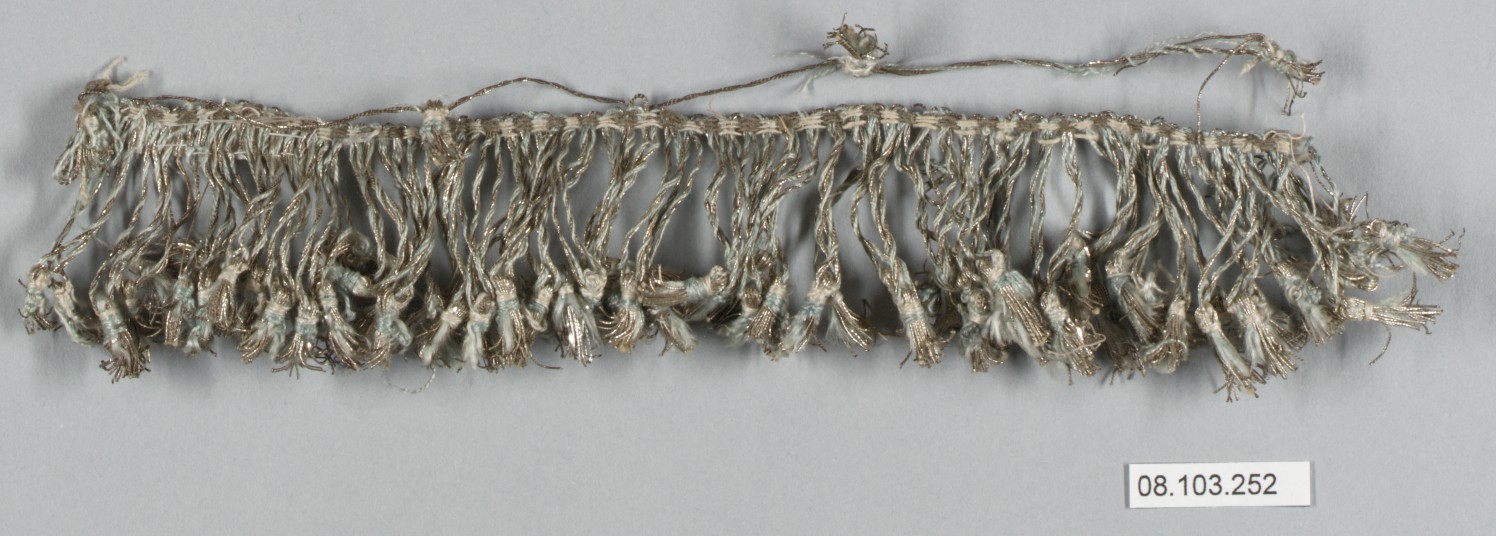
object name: fringe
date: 1601-1800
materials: metal thread, silk